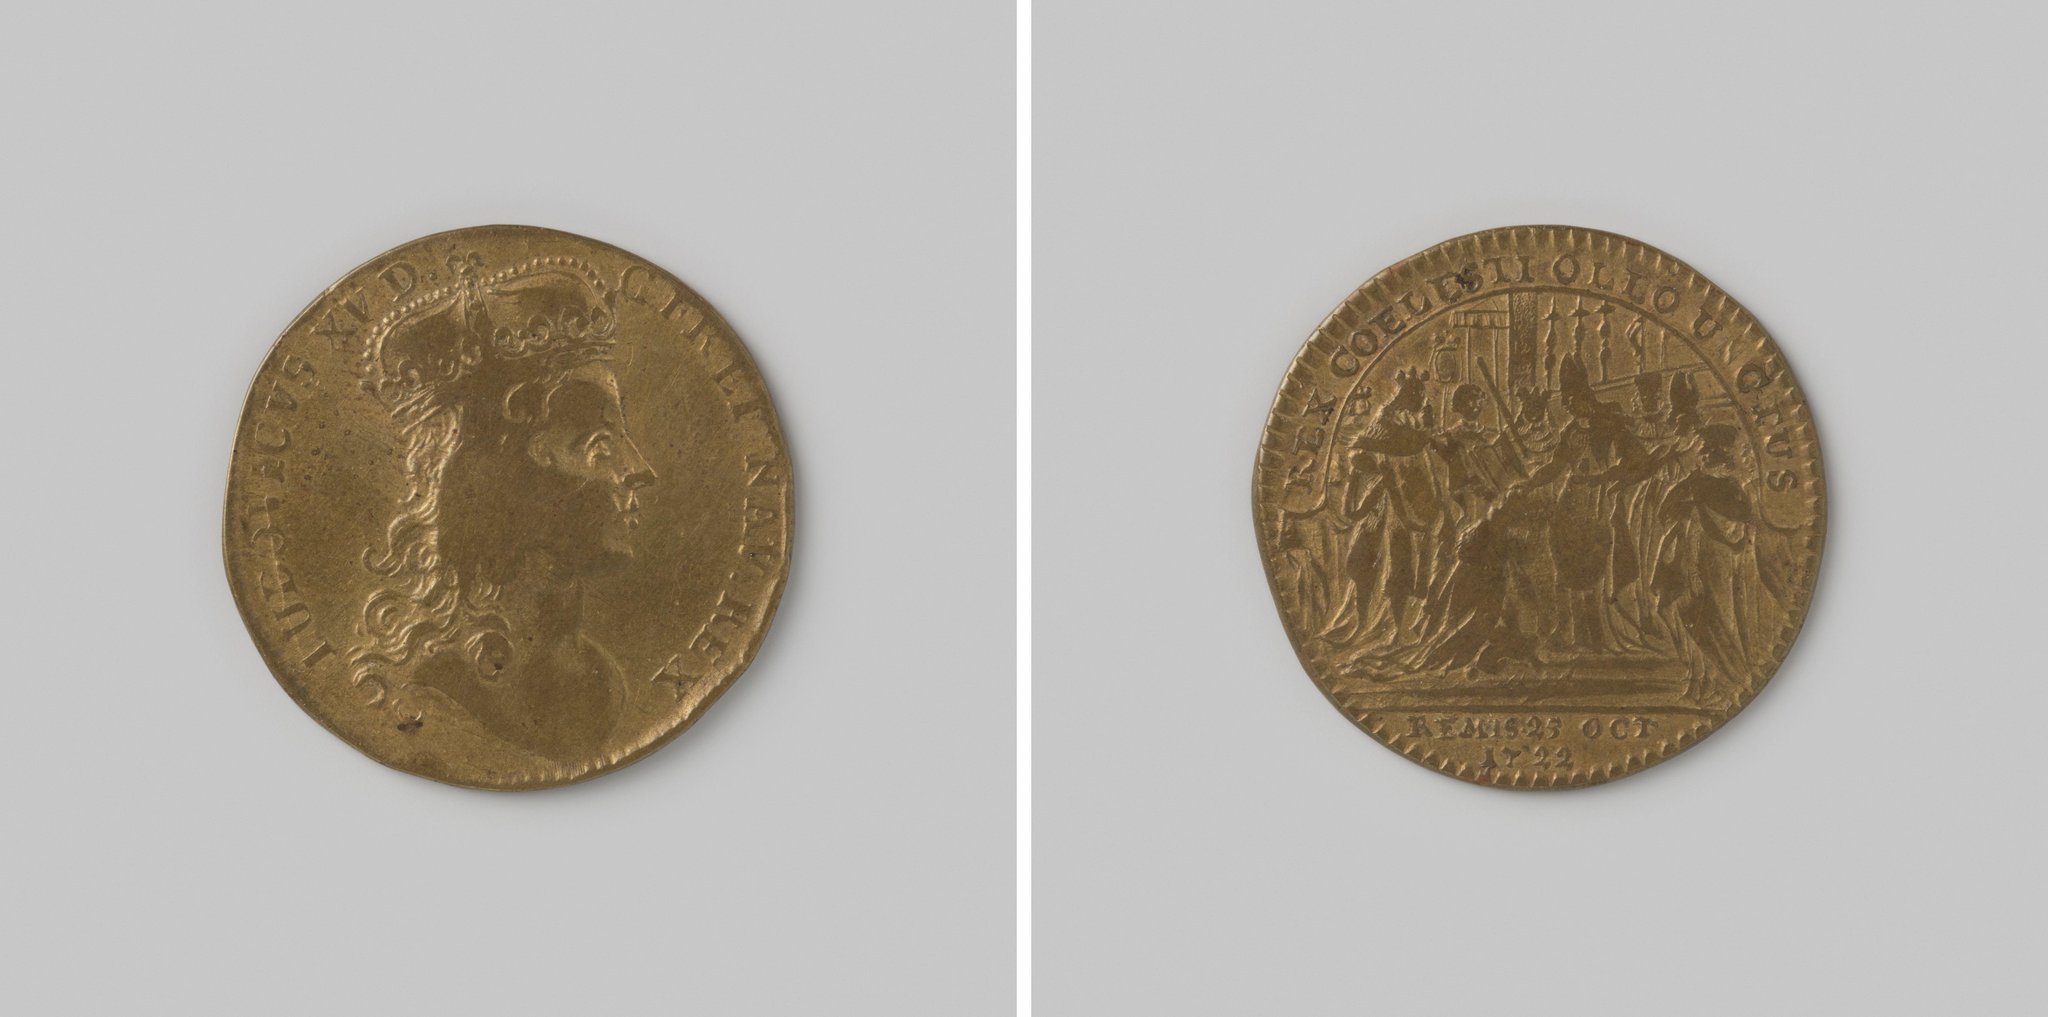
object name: history medal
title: Franse jeton op de zalving van Koning Lodewijk XV te Reims 1722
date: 1722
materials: brass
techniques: striking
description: Messing penning, op de voorzijde het portret van Lodewijk XV naar rechts met omschrift, op de keerzijde de kroningsscene, met omschrift en afsnedetekst.